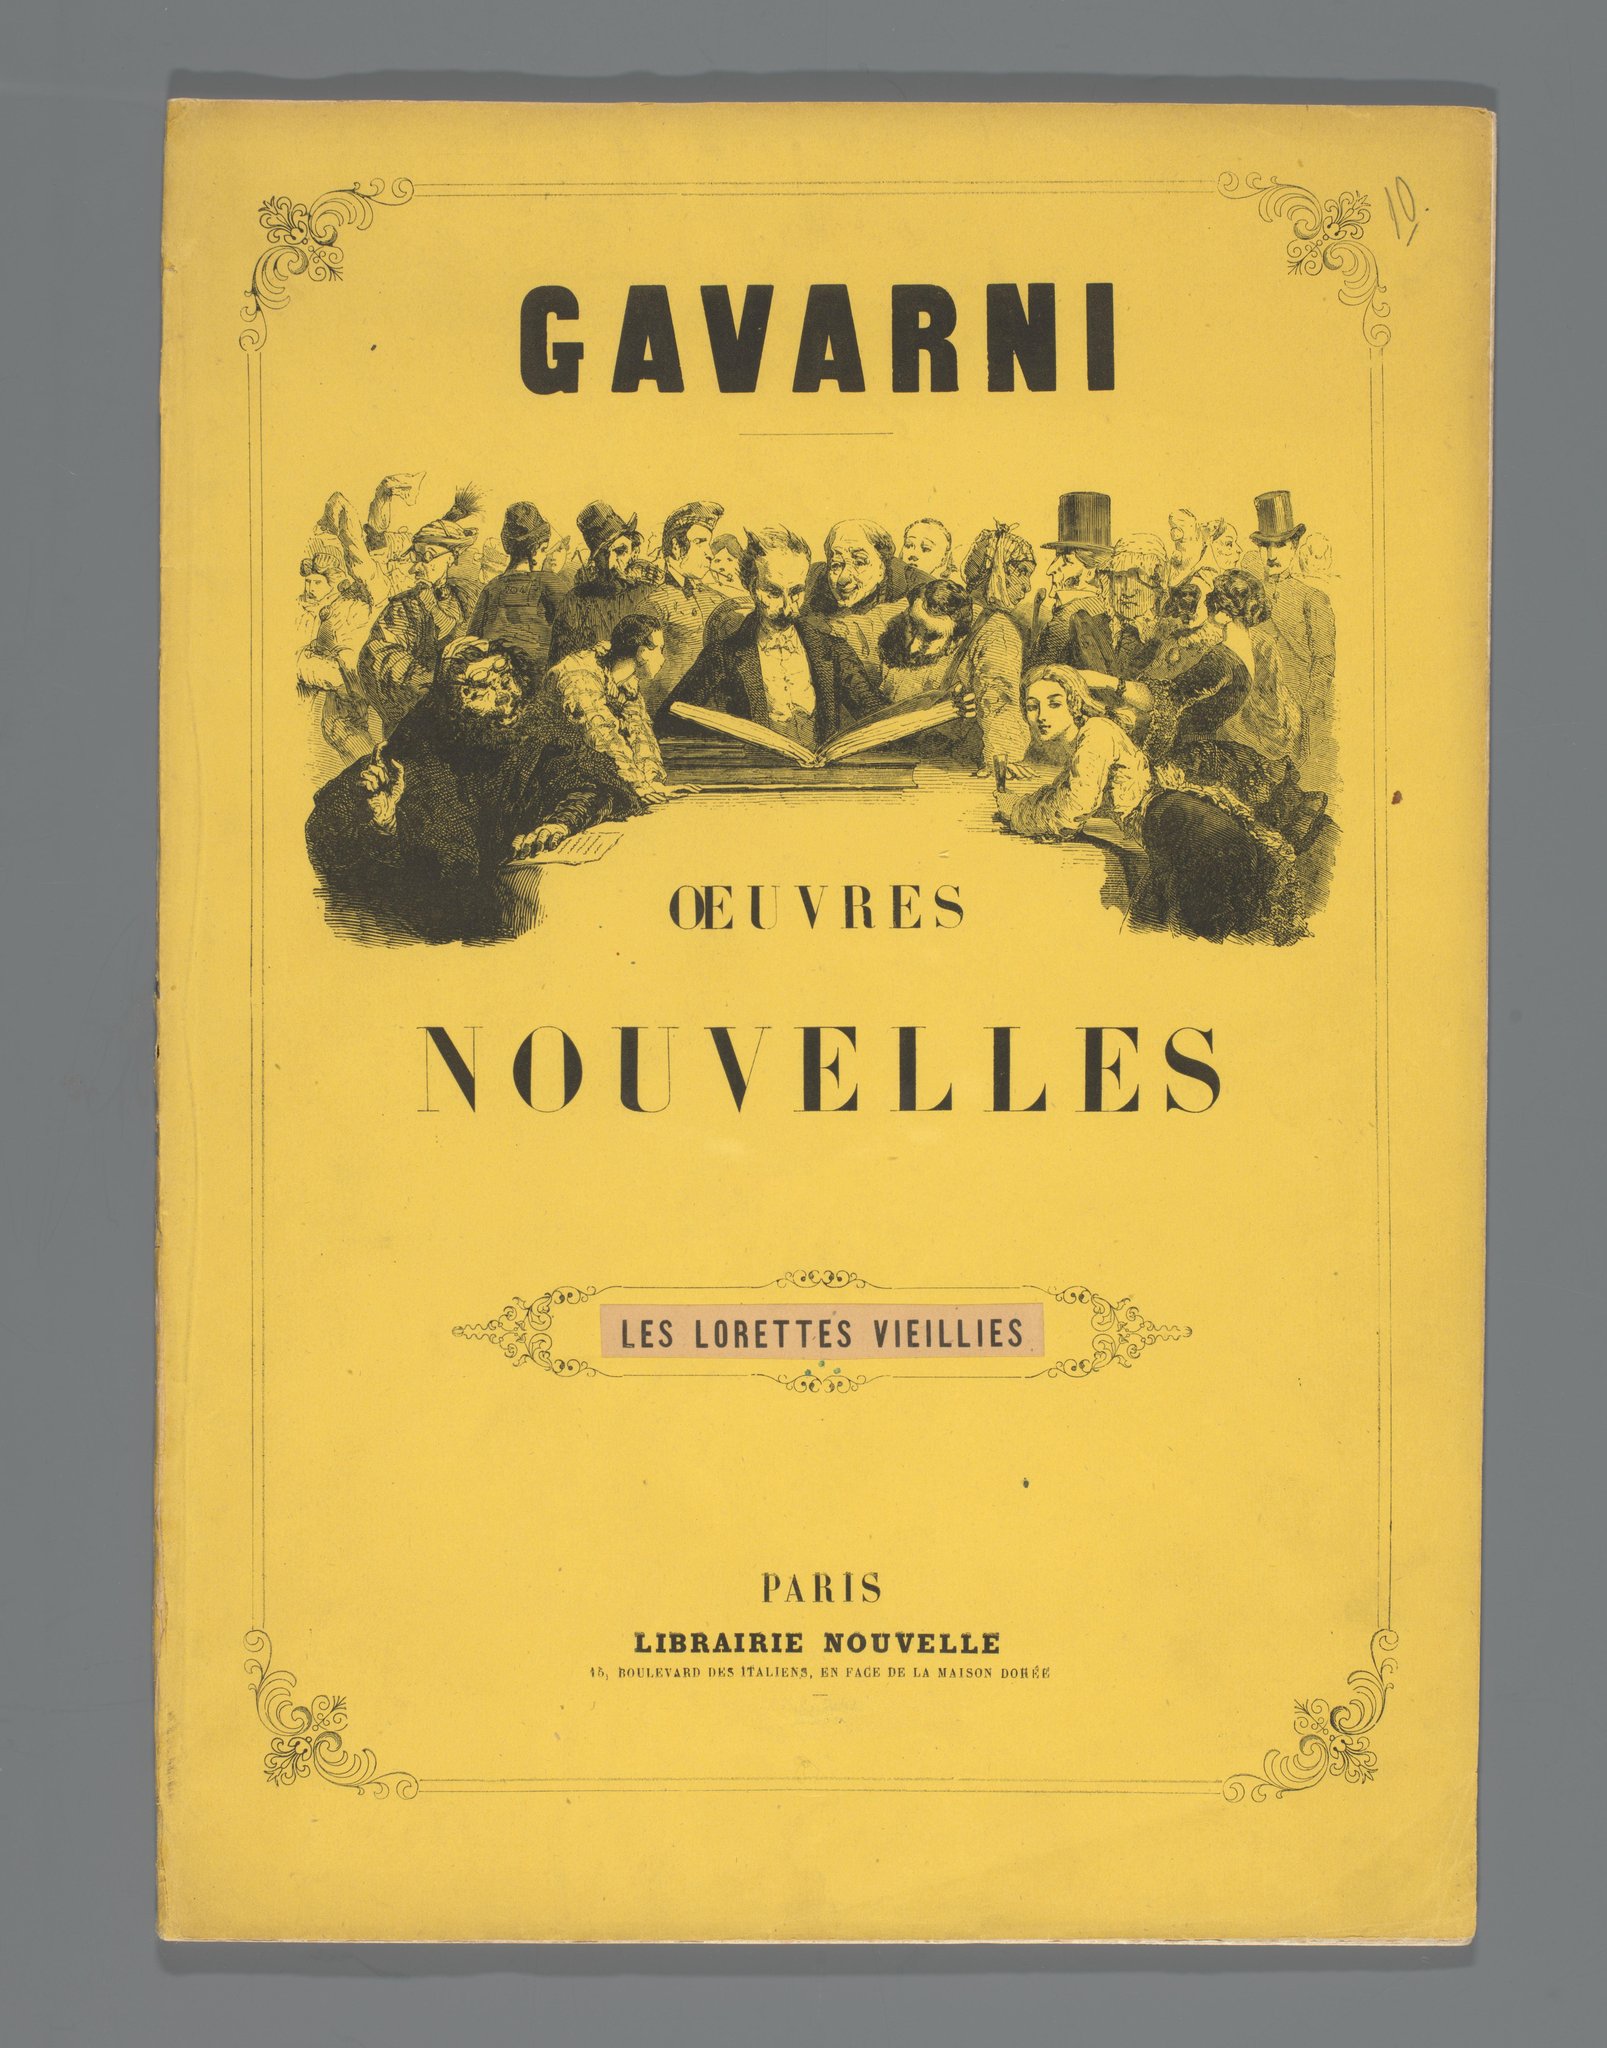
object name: prentrecueil, prentenalbum, prentalbum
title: Oude vrouwen uit Notre-Dame-de-Lorette in Parijs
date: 1853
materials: paper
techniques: lithograph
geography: paris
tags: print, e.g.: engraving, etching, lithograph, art collector, old woman, various human types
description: Album met tien prenten op tien bladen. Op de omslag slaat een prentverzamelaar een album open. Hij wordt omringd door verschillende menselijke figuren.